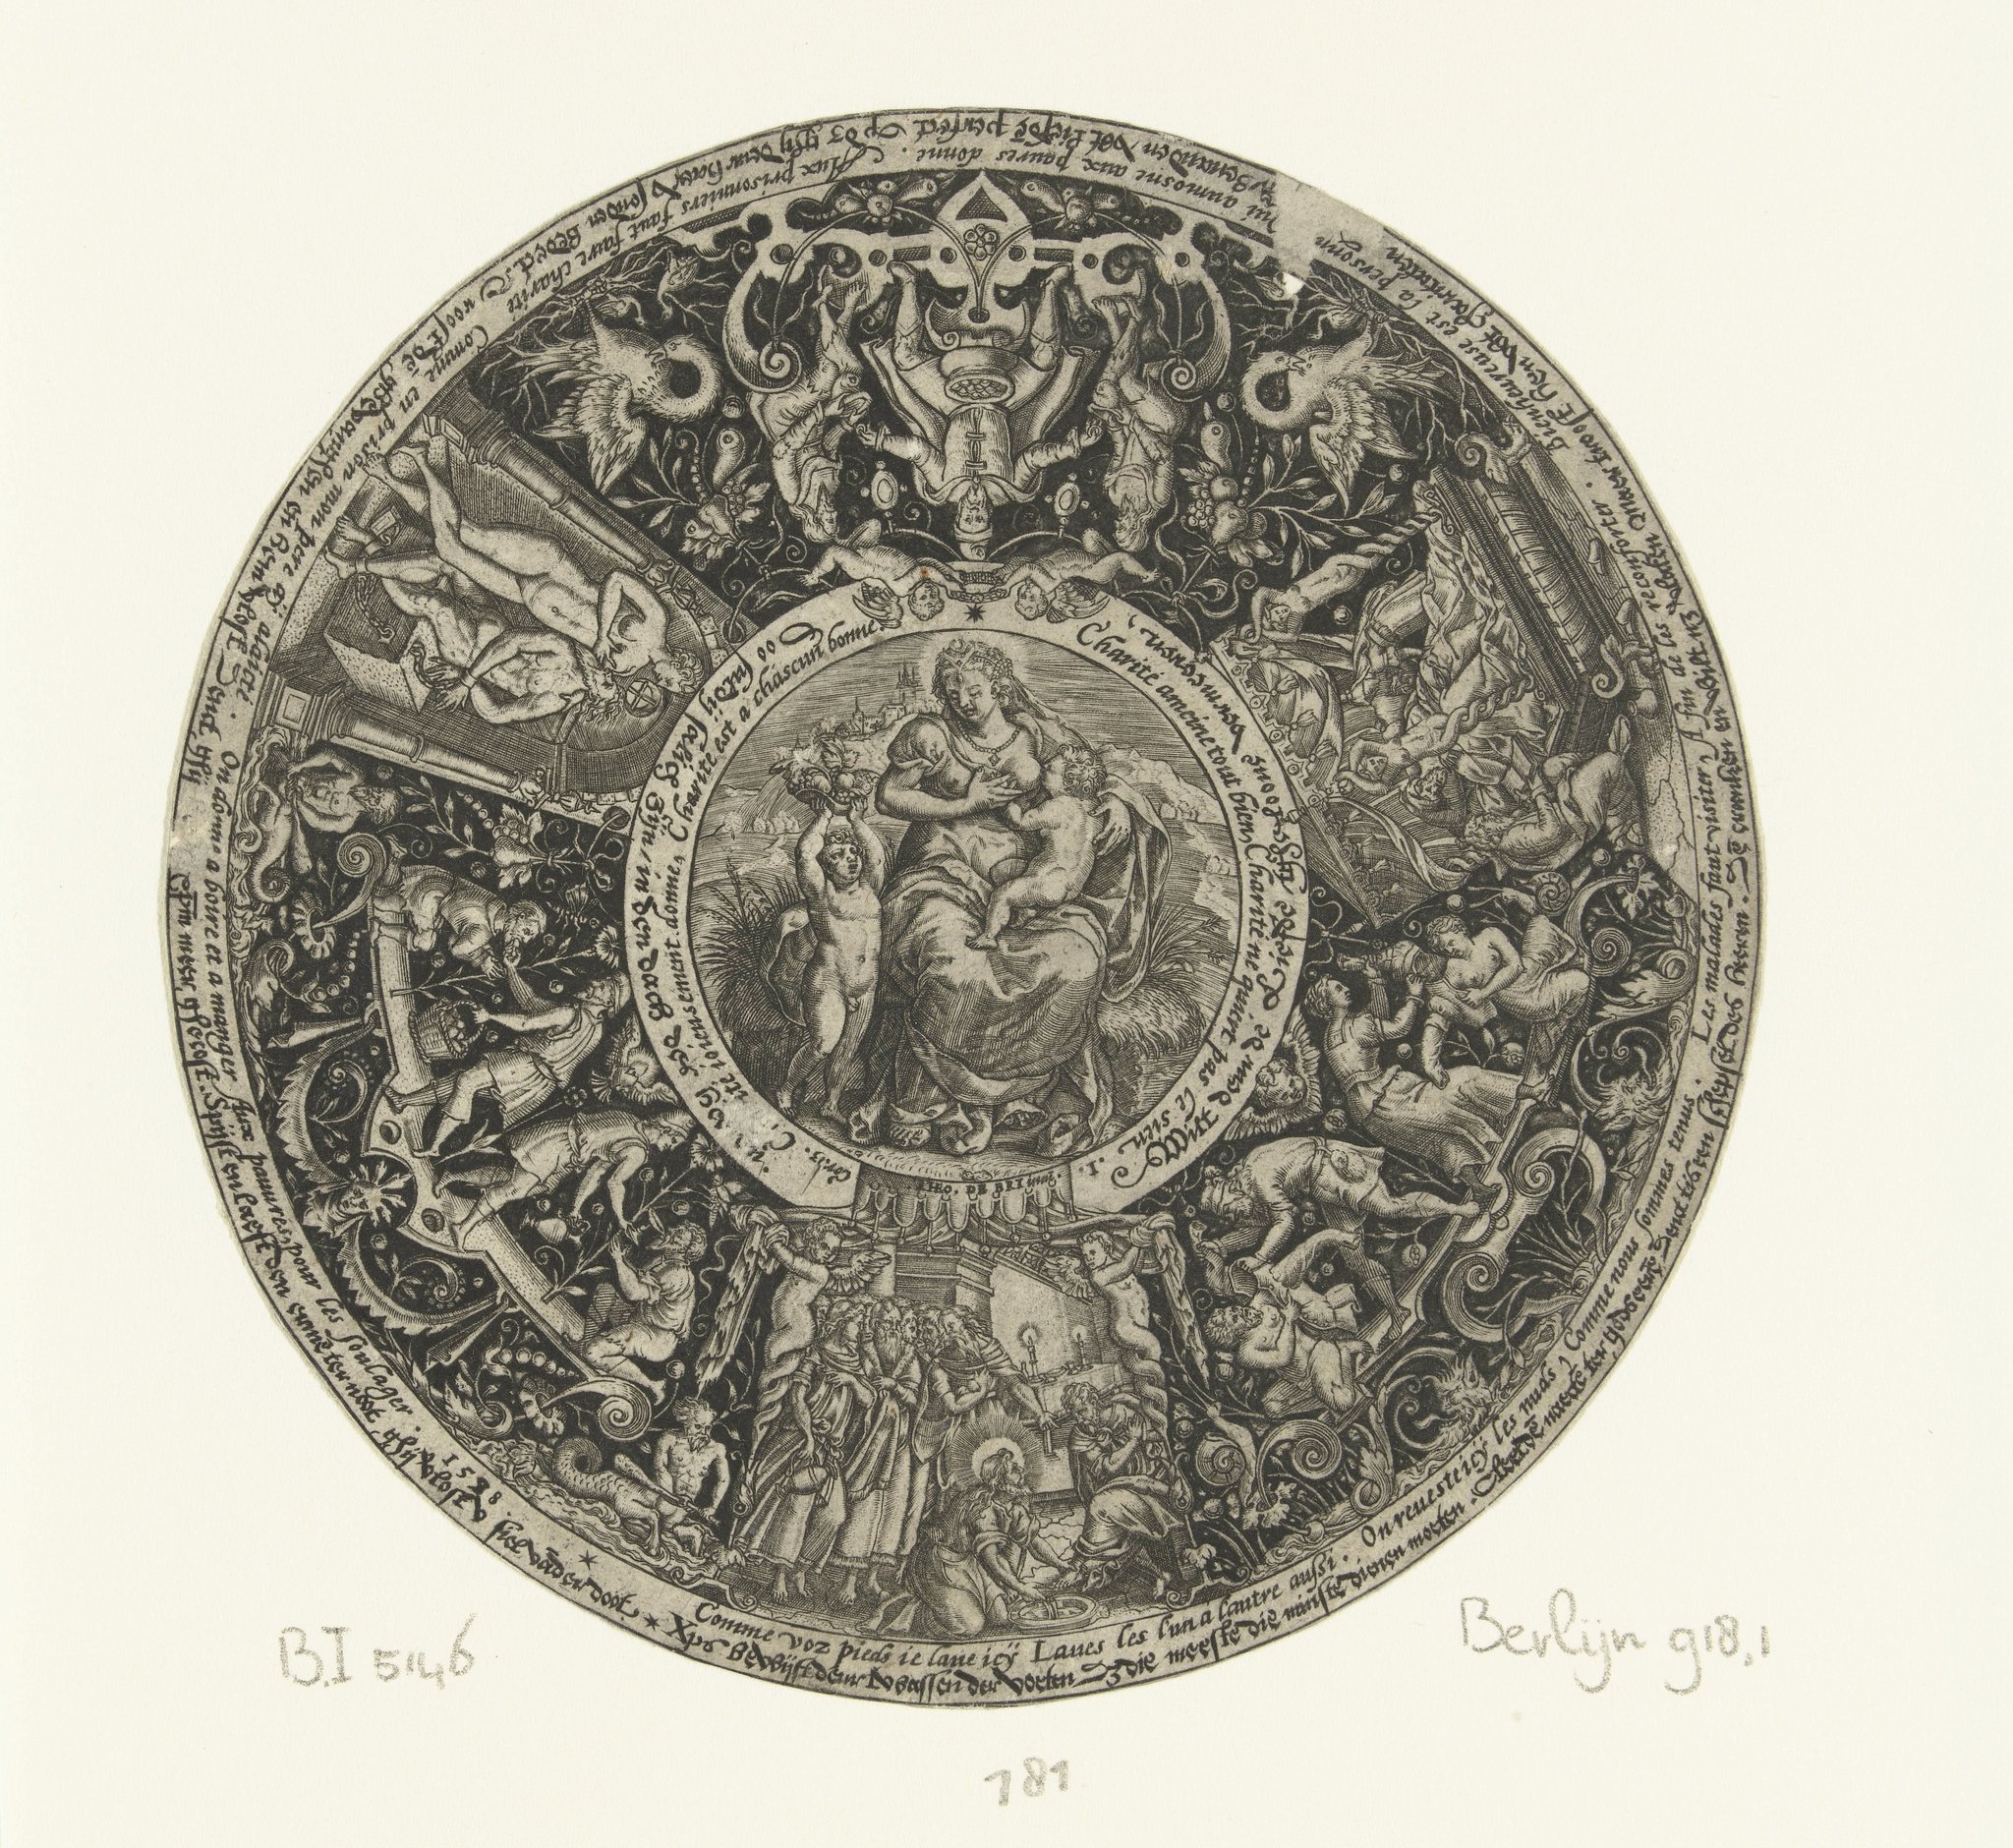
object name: print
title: Medaillon met Caritas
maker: theodor de bry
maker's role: draughtsman, print maker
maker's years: 1528-1598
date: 1588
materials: paper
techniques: engraving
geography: netherlands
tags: charity, 'caritas'; 'carità' (ripa) ~ one of the three theological virtues, the (seven) acts of mercy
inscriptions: date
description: De rand is gedecoreerd met grotesken die vijf van de zeven werken van barmhartigheid als thema hebben. Middenonder een voorstelling van de voetwassing. Blad uit serie van 4 bladen met een medaillon in een brede rand van grotesken met figuren, dieren en bladranken op een donker fond. De rand rondom het medaillon en de buitenrand bevatten Nederlandse en Franse versregels.